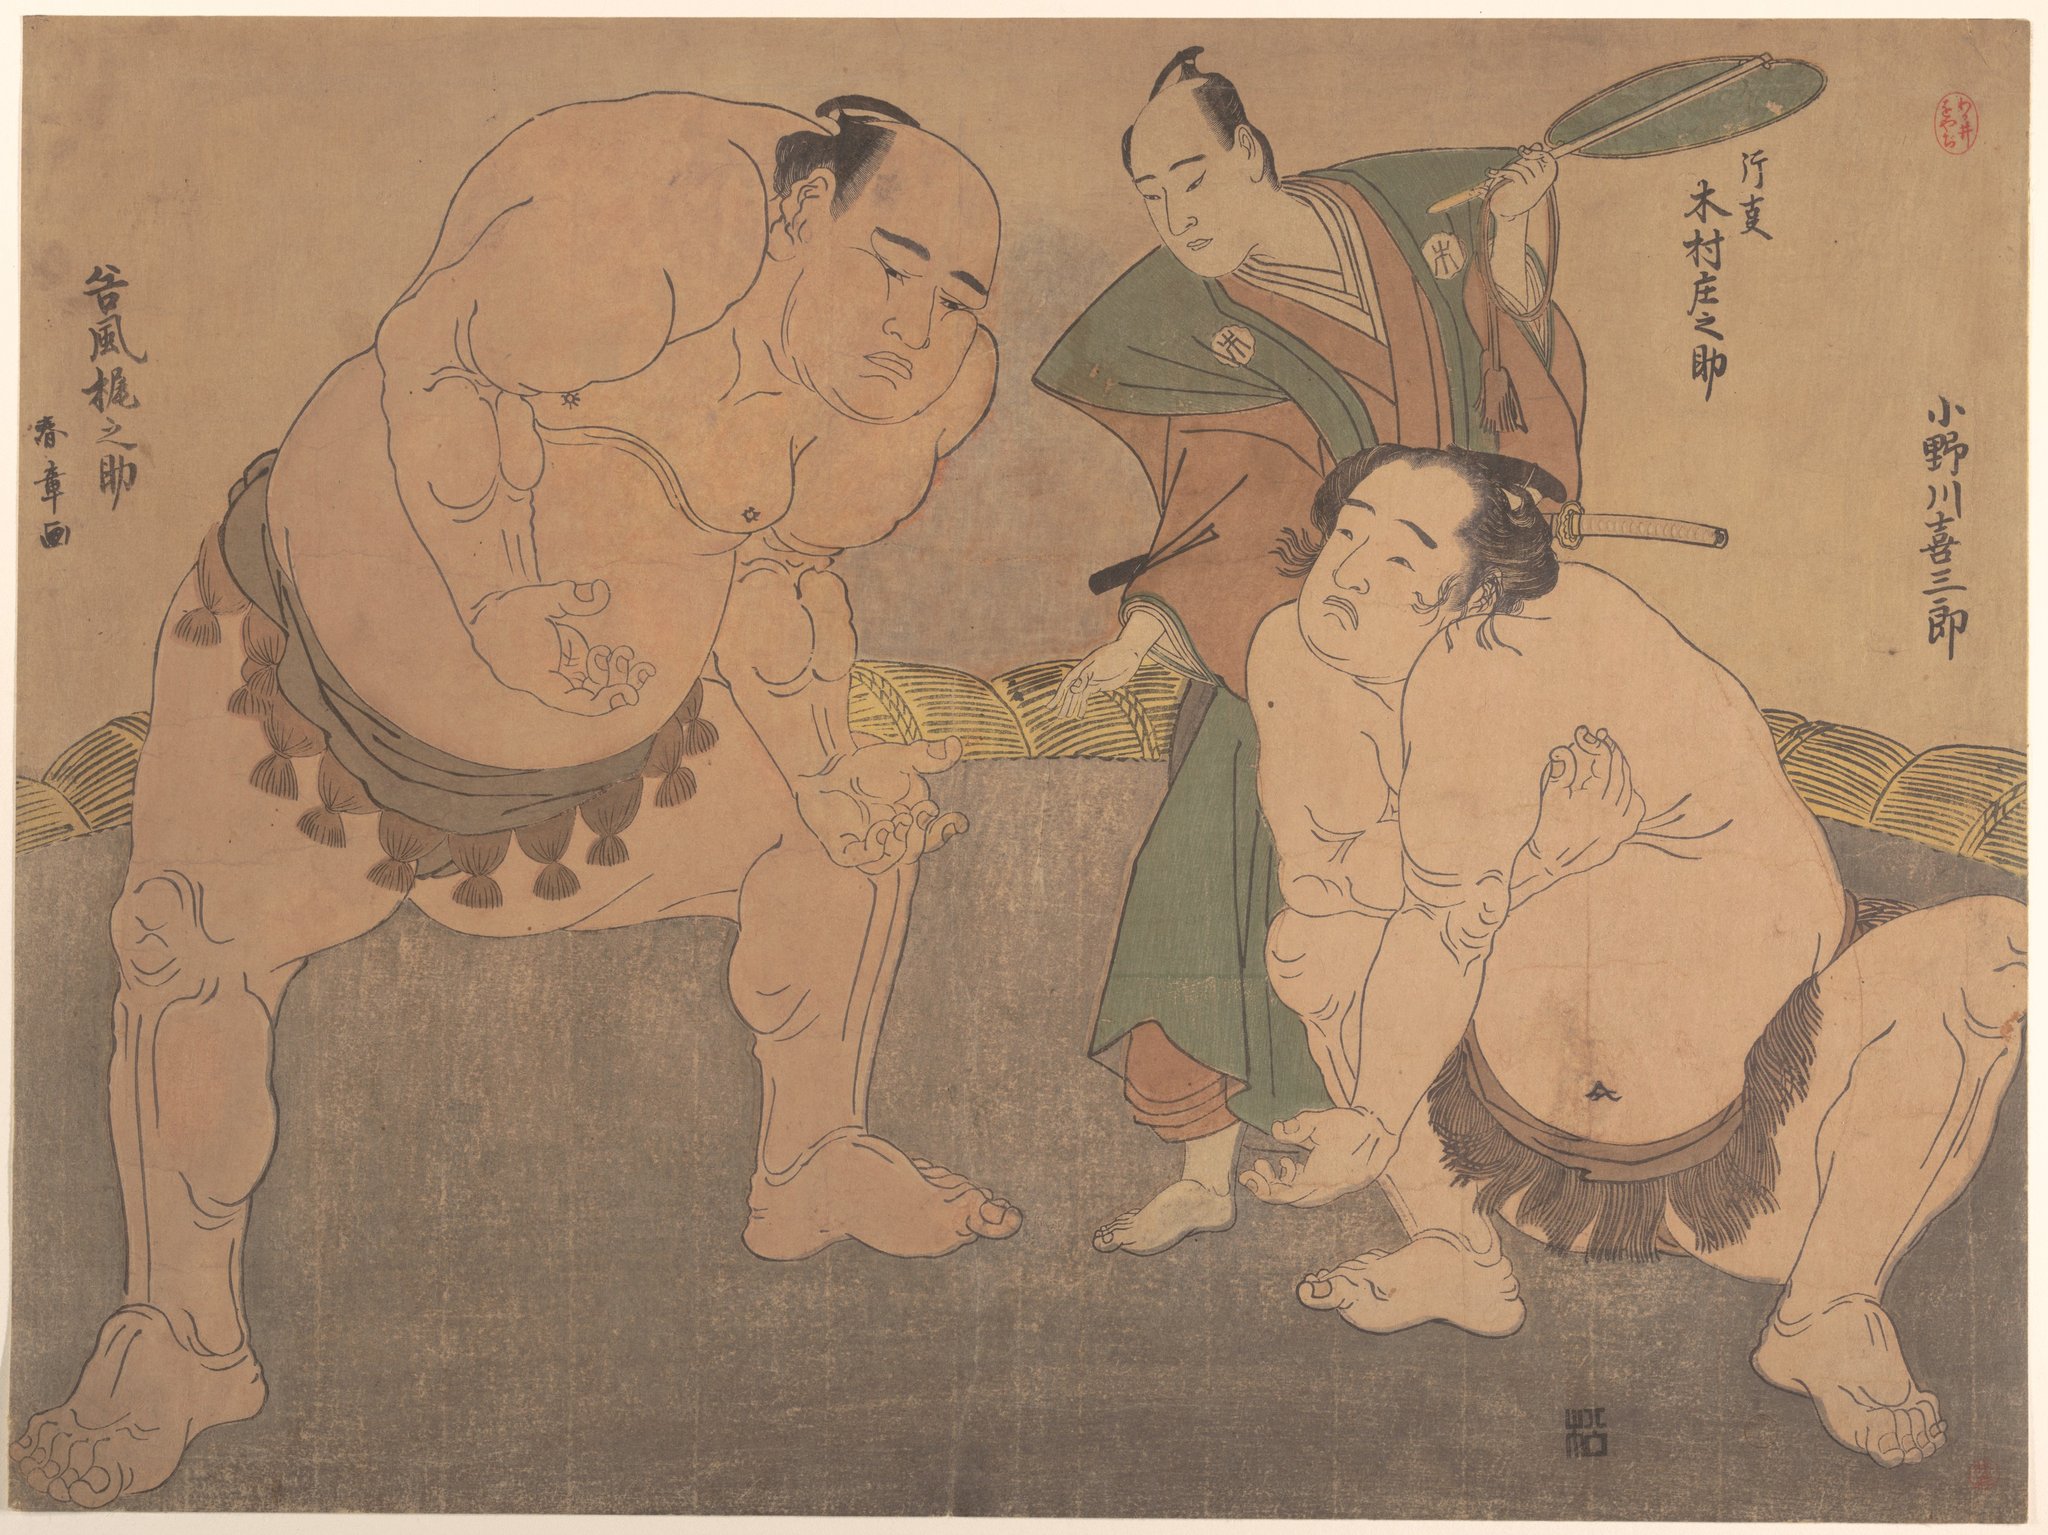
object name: woodblock print nishiki e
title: The Wrestlers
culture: japanese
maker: katsukawa shunshō 勝川春章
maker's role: artist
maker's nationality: japanese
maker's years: 1726-1792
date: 1785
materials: ink, paper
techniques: nishiki e, woodblock print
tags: men,wrestling